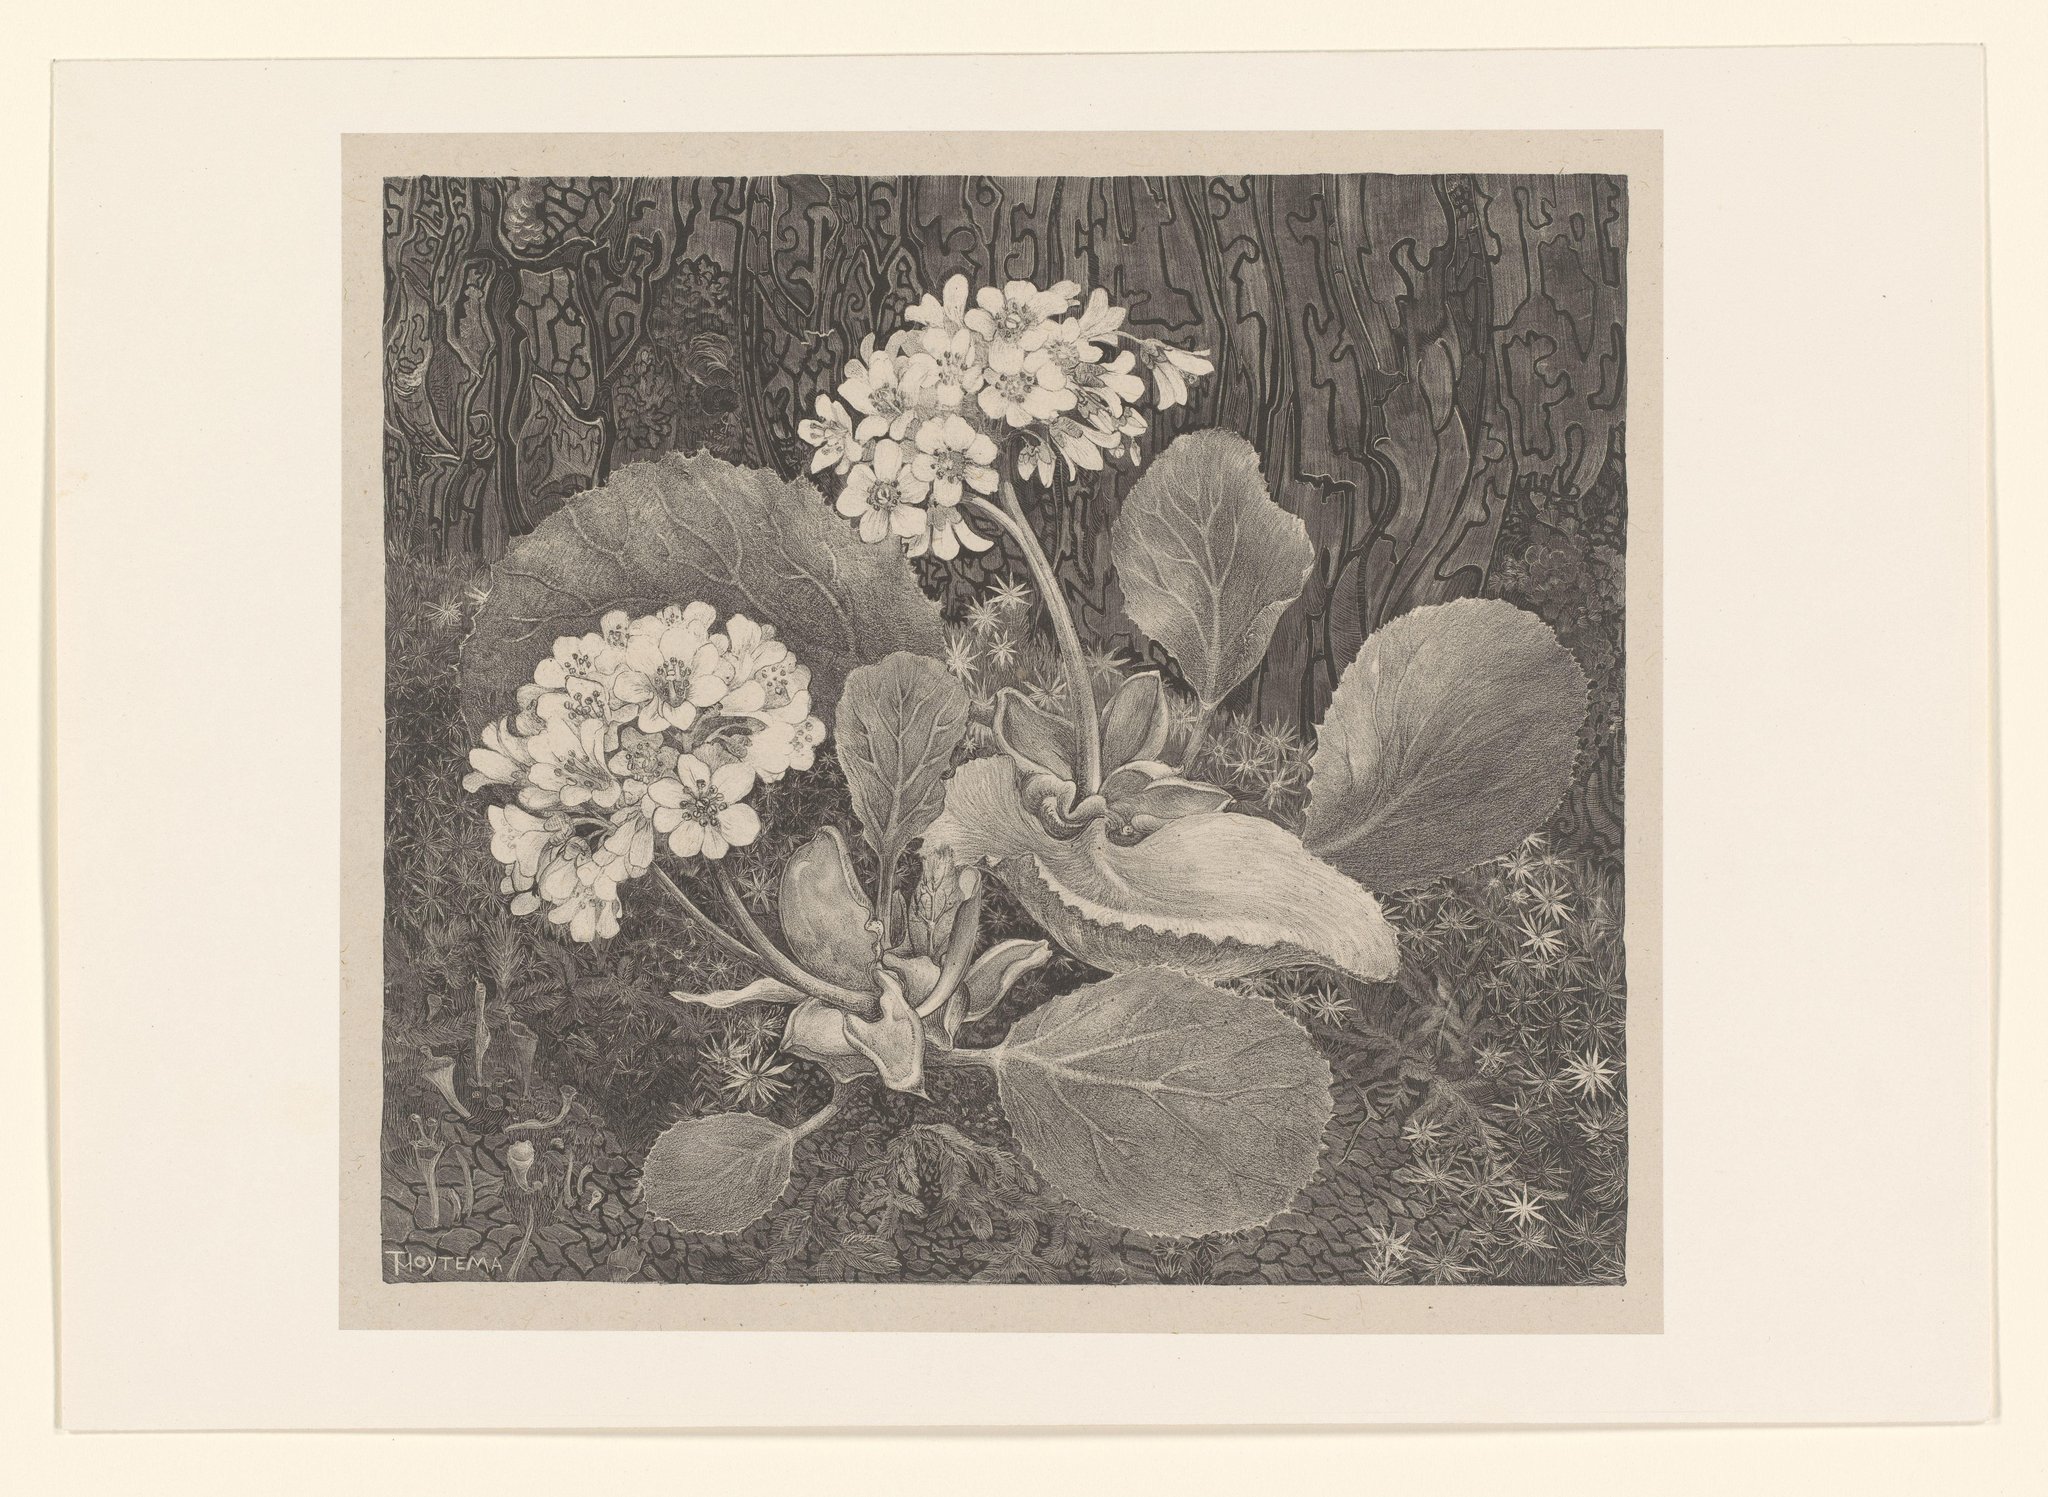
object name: print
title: Primula in het mos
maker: theo van hoytema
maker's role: draughtsman, painter, print maker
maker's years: 1863-1917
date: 1898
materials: paper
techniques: blind stamped, lithograph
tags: flowers, mosses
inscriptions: collector's mark: Lugt 2233